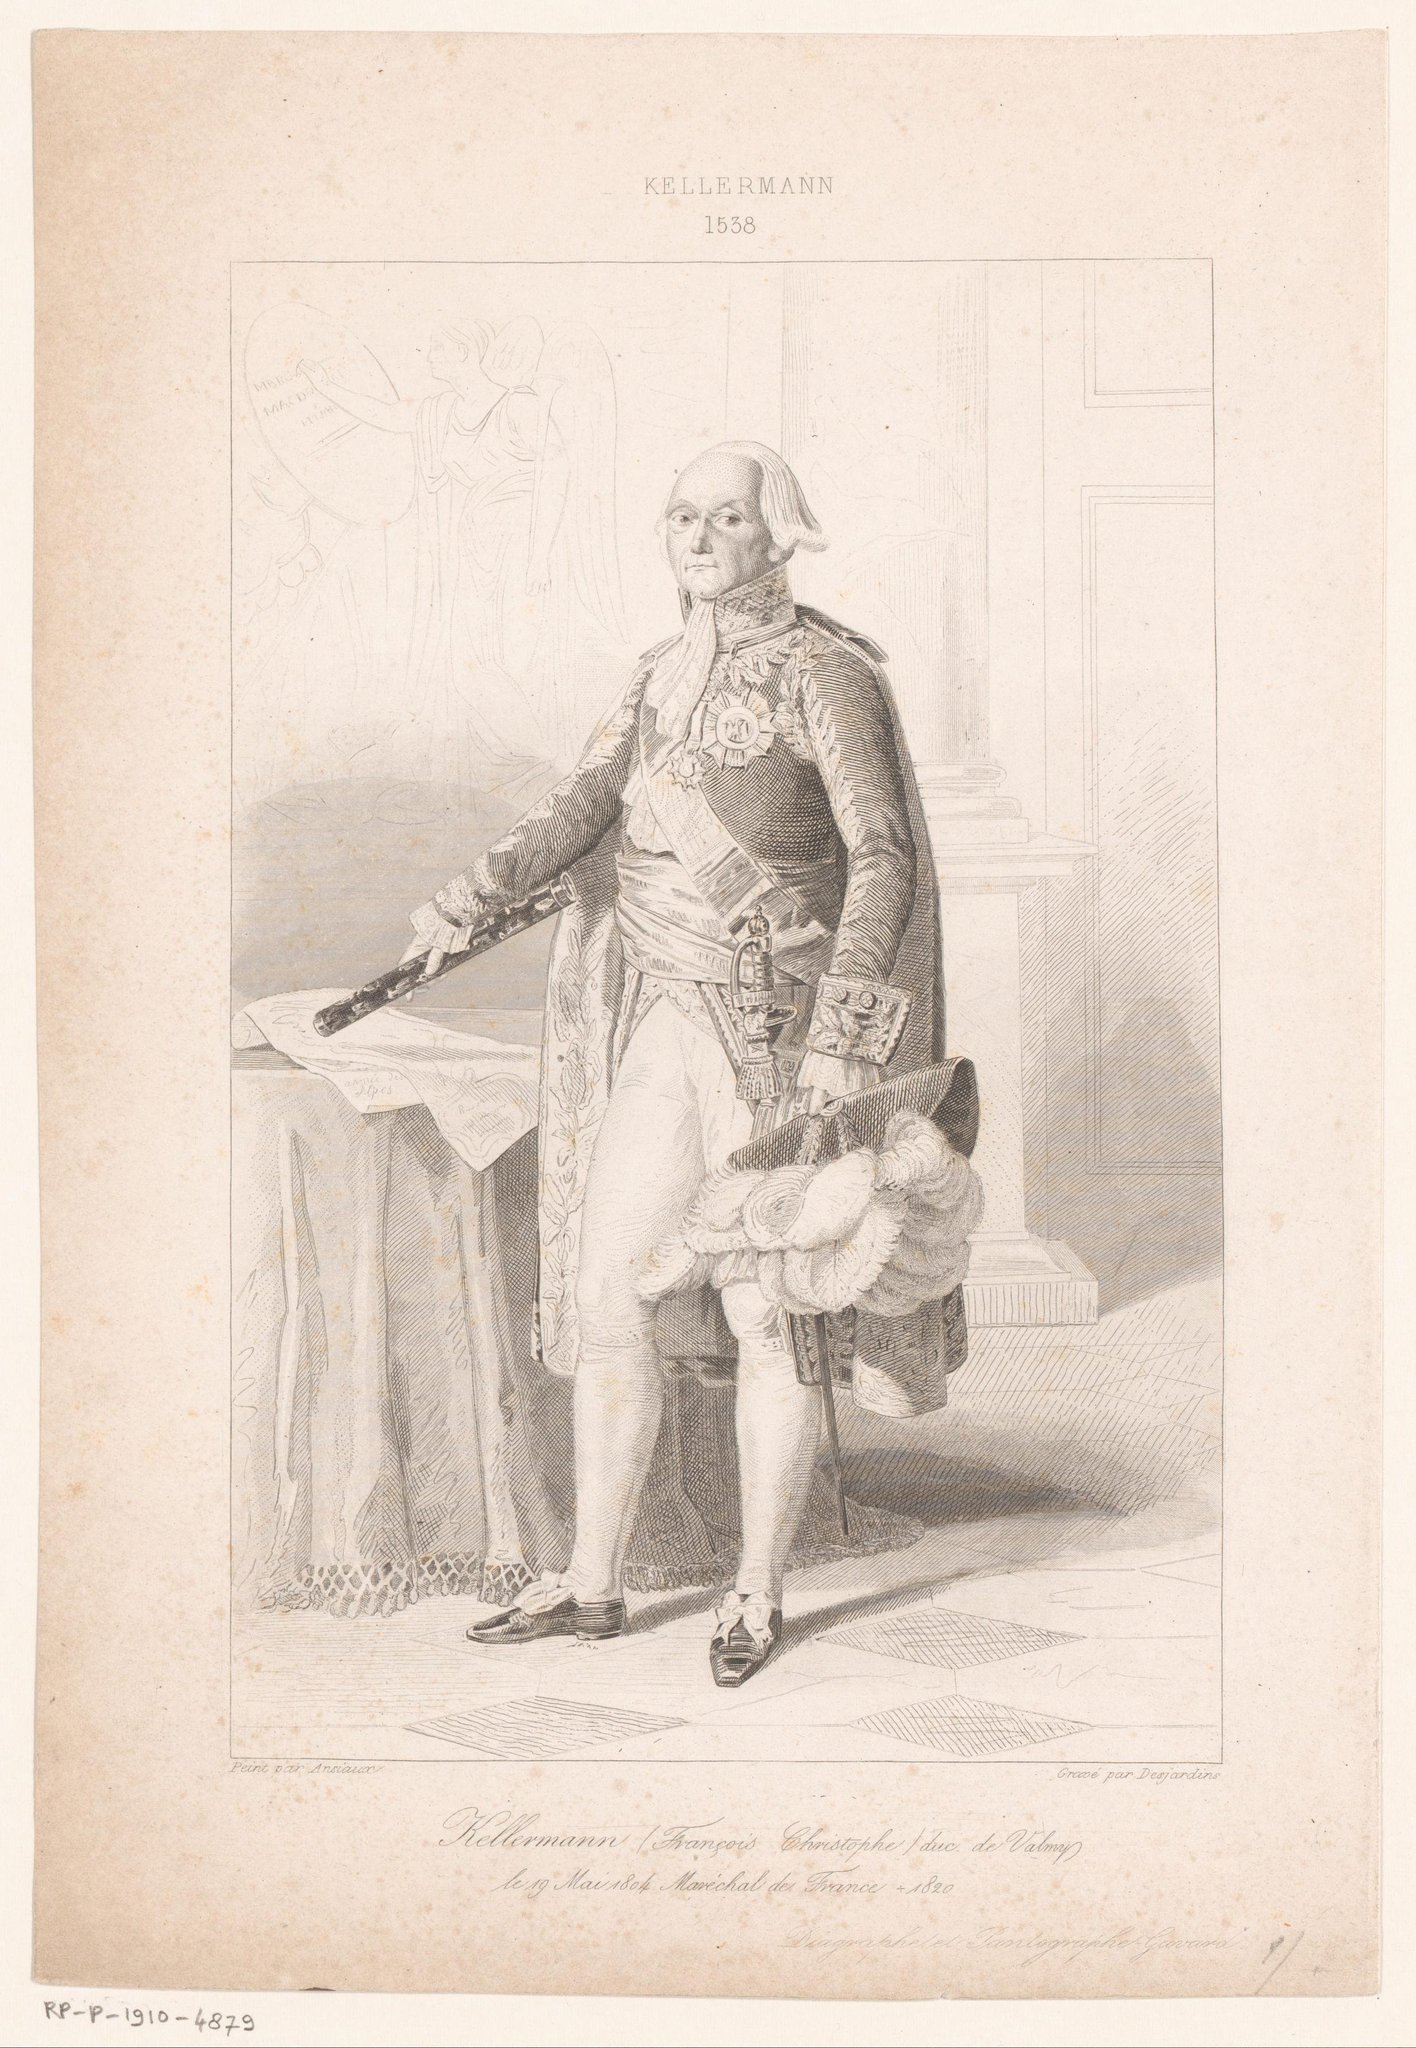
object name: print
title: Portret van François Christophe Kellermann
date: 1838-1841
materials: paper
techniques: engraving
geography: paris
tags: paris, ranks in the army, historical persons, decorations, honours (as symbols of the state, etc.)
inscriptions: collector's mark: Lugt 2228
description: Prent uit: s.n. Galeries historiques de Versailles. Parijs: Charles Gavard, 1838-1841.